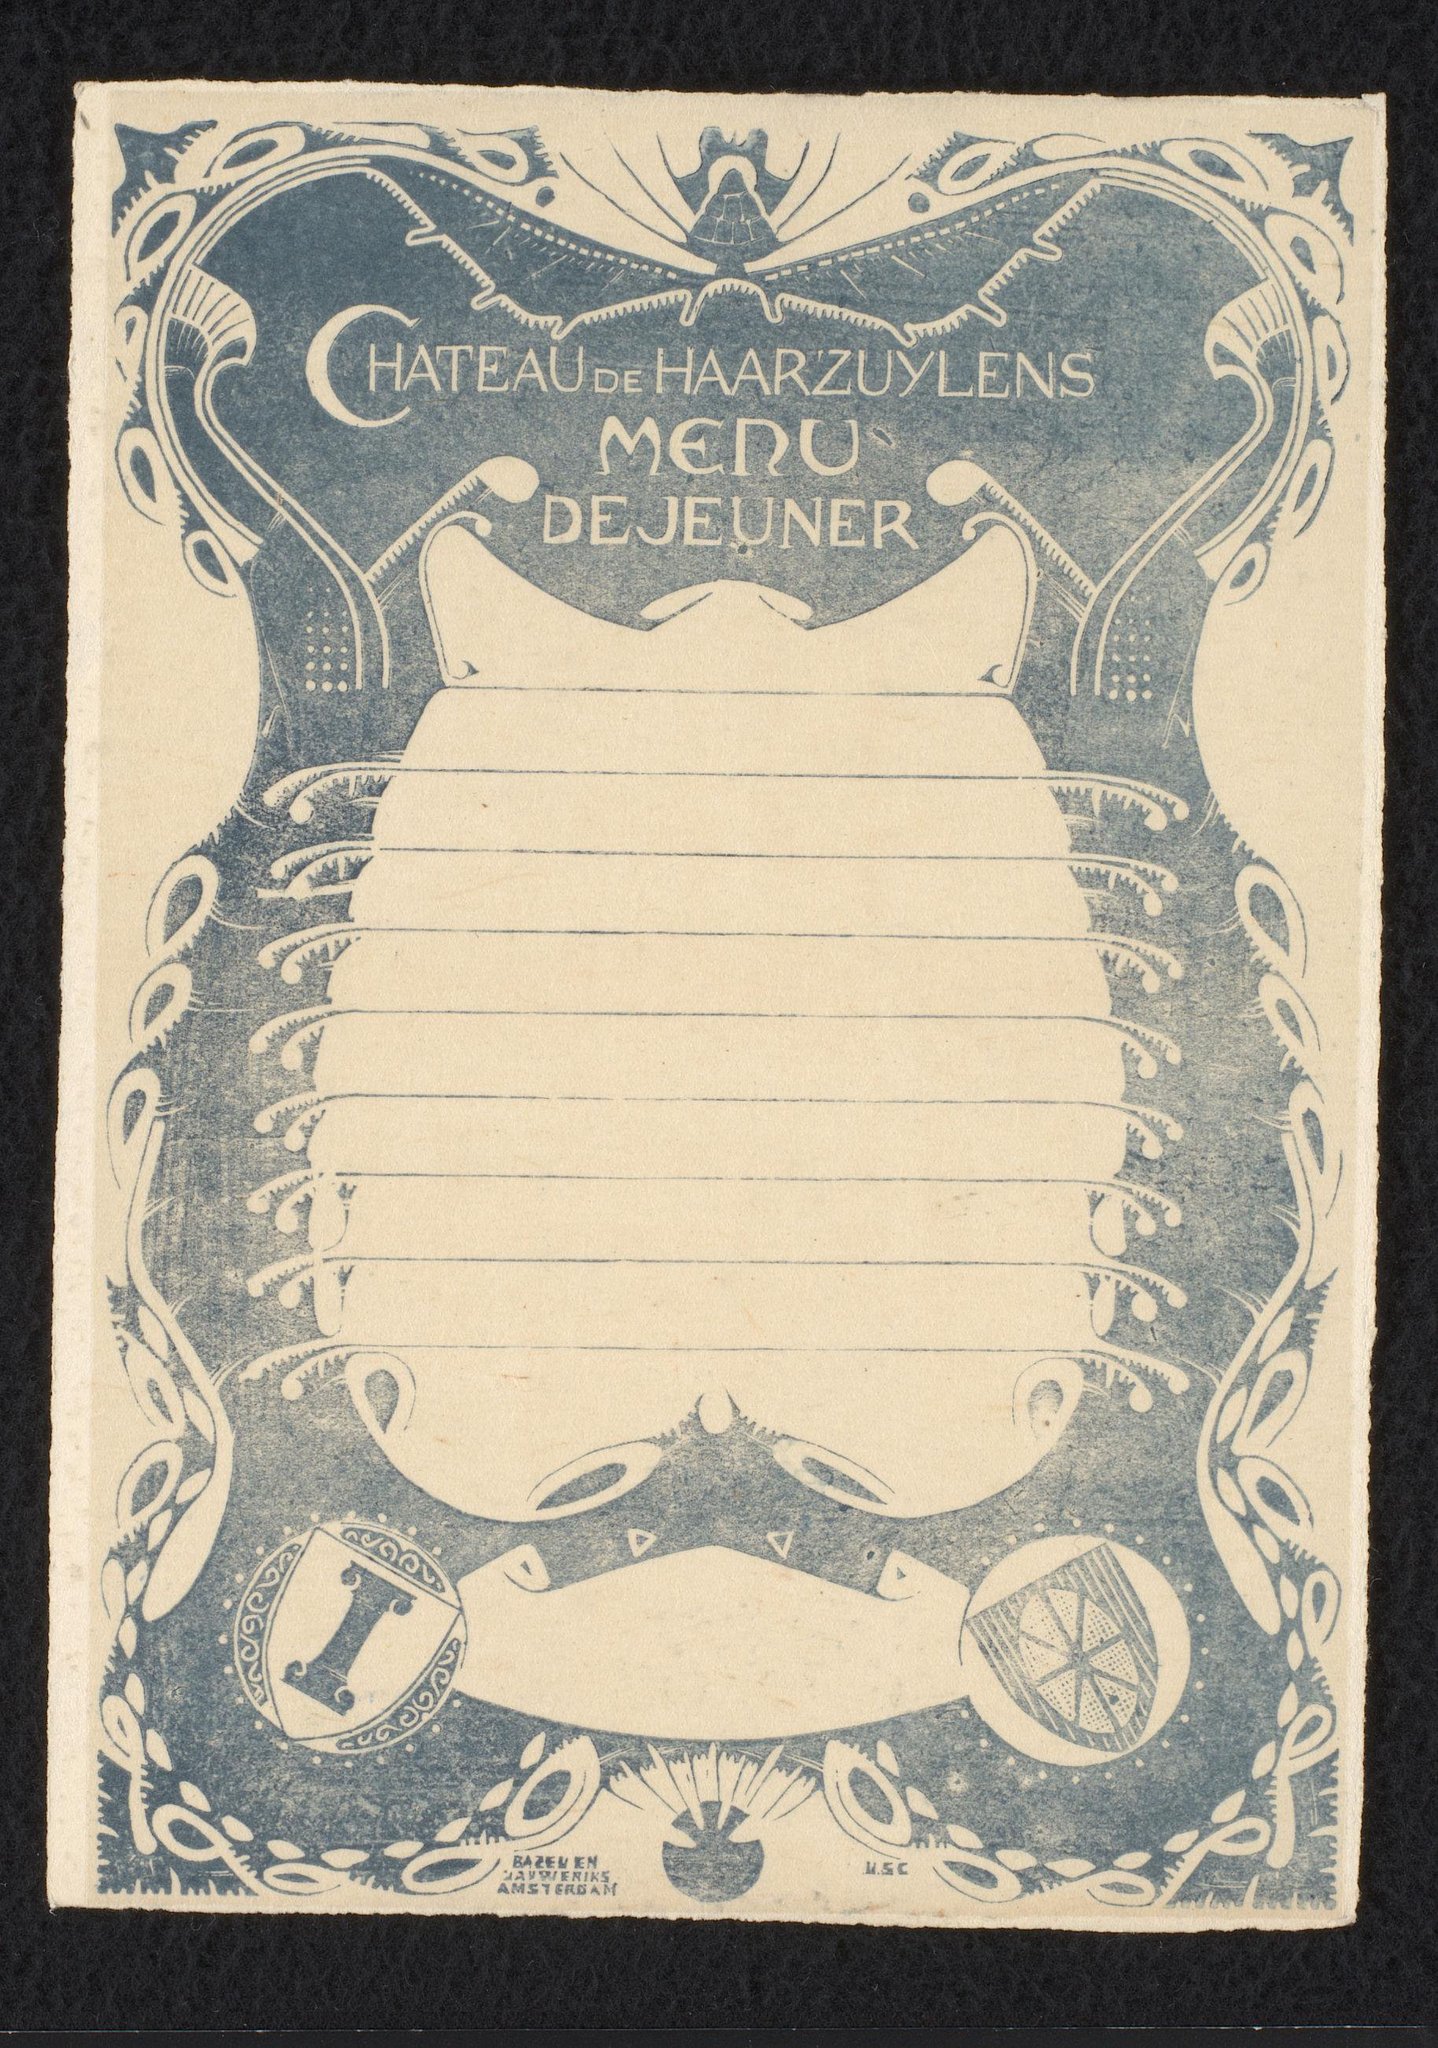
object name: print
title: Menukaart Château de Haarzuylens déjeuner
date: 1896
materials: paper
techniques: woodcut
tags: ornaments ~ art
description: Menukaart voor kasteel De Haar in Haarzuilens.